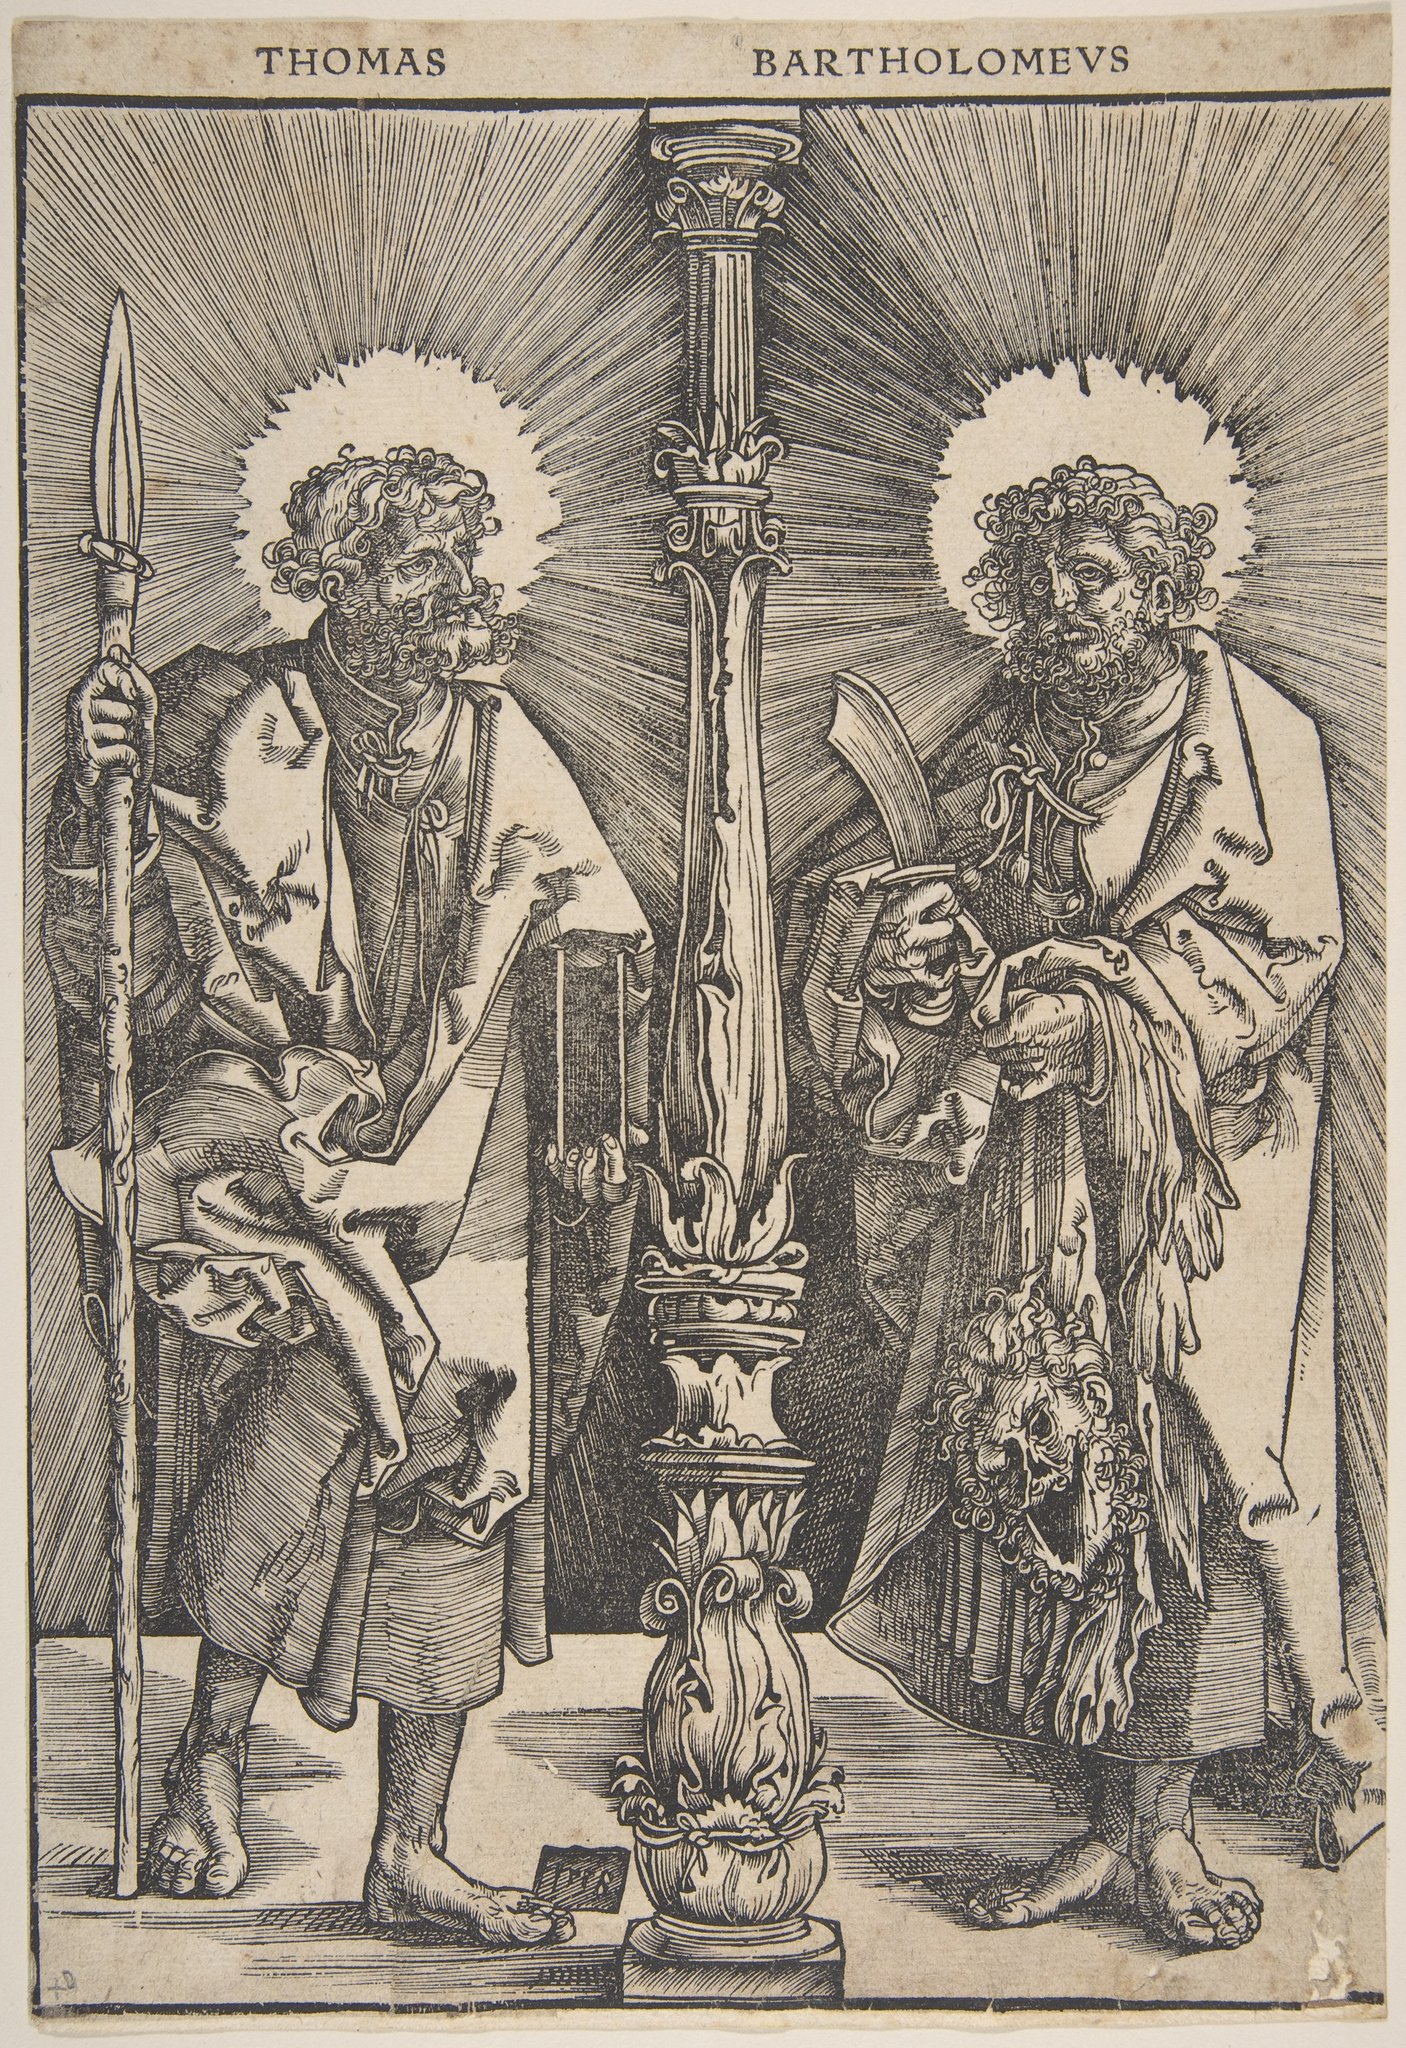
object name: print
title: Sts. Thomas and Bartholomew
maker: monogrammist g.z.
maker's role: artist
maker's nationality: german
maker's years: 1514-1521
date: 1518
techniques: woodcut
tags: spears,apostles